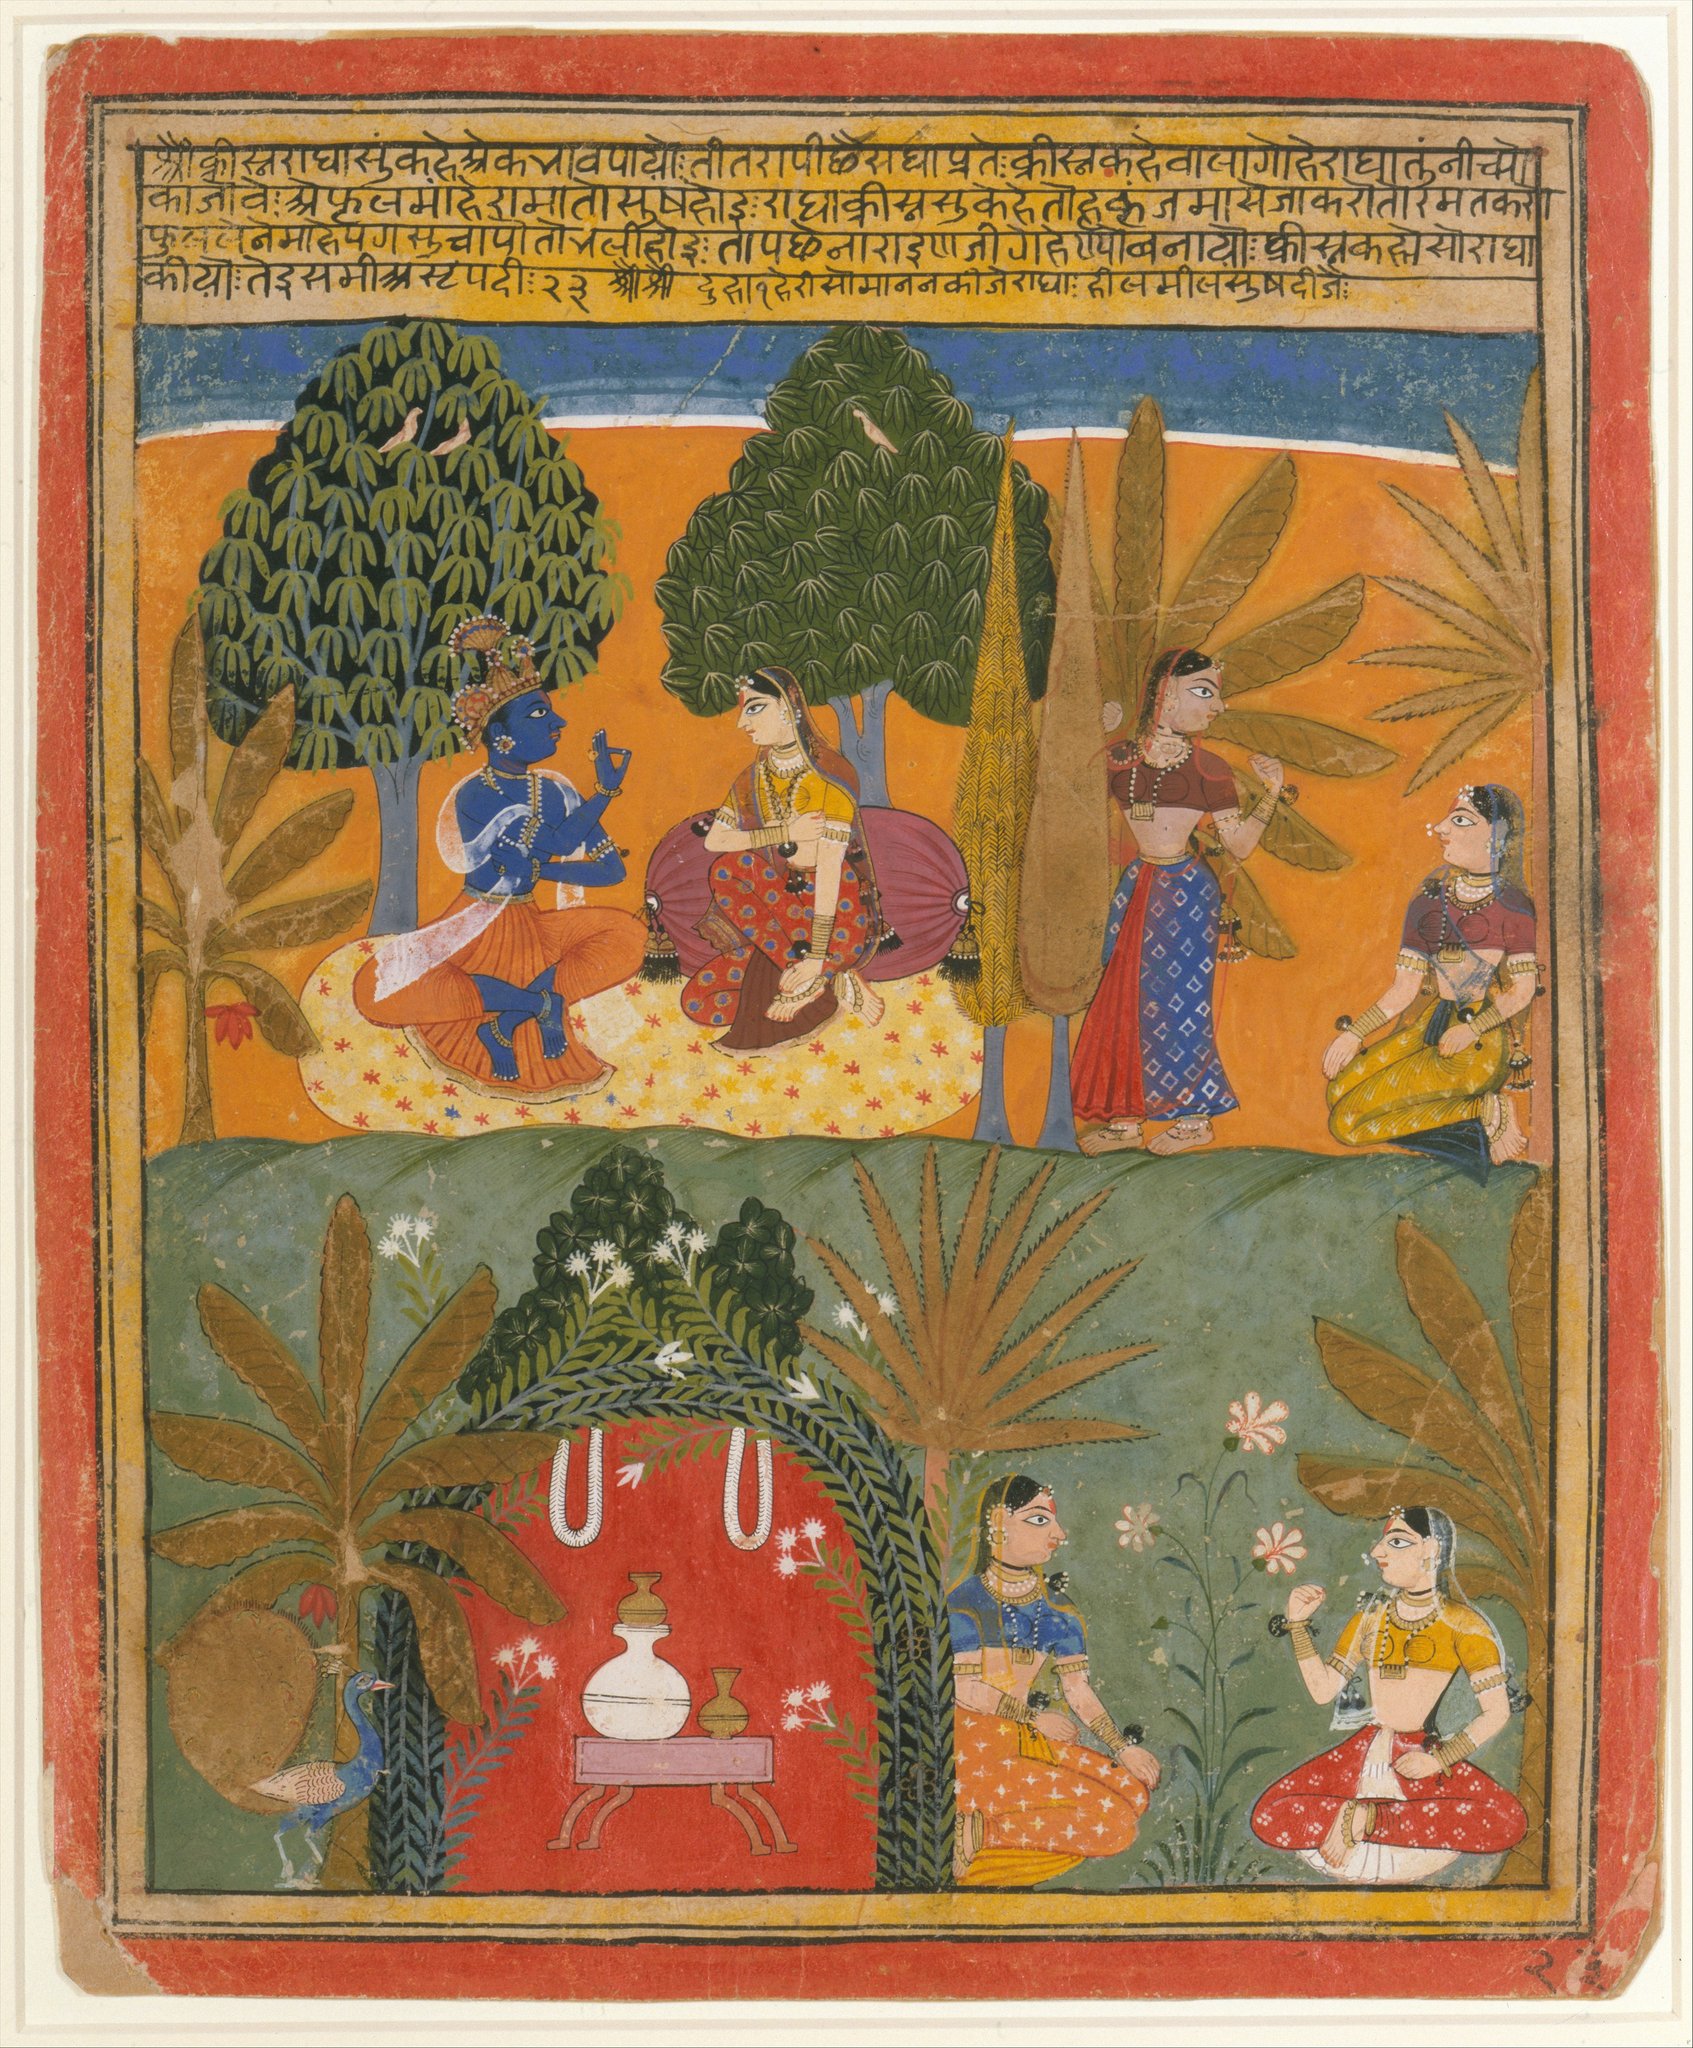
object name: folio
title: Krishna and Radha with Their Confidantes: Page from a Dispersed Gita Govinda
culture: mewar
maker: manohar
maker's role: artist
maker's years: 1577-1624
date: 1655-1660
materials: ink, paper, watercolor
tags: women,trees,krishna,radha